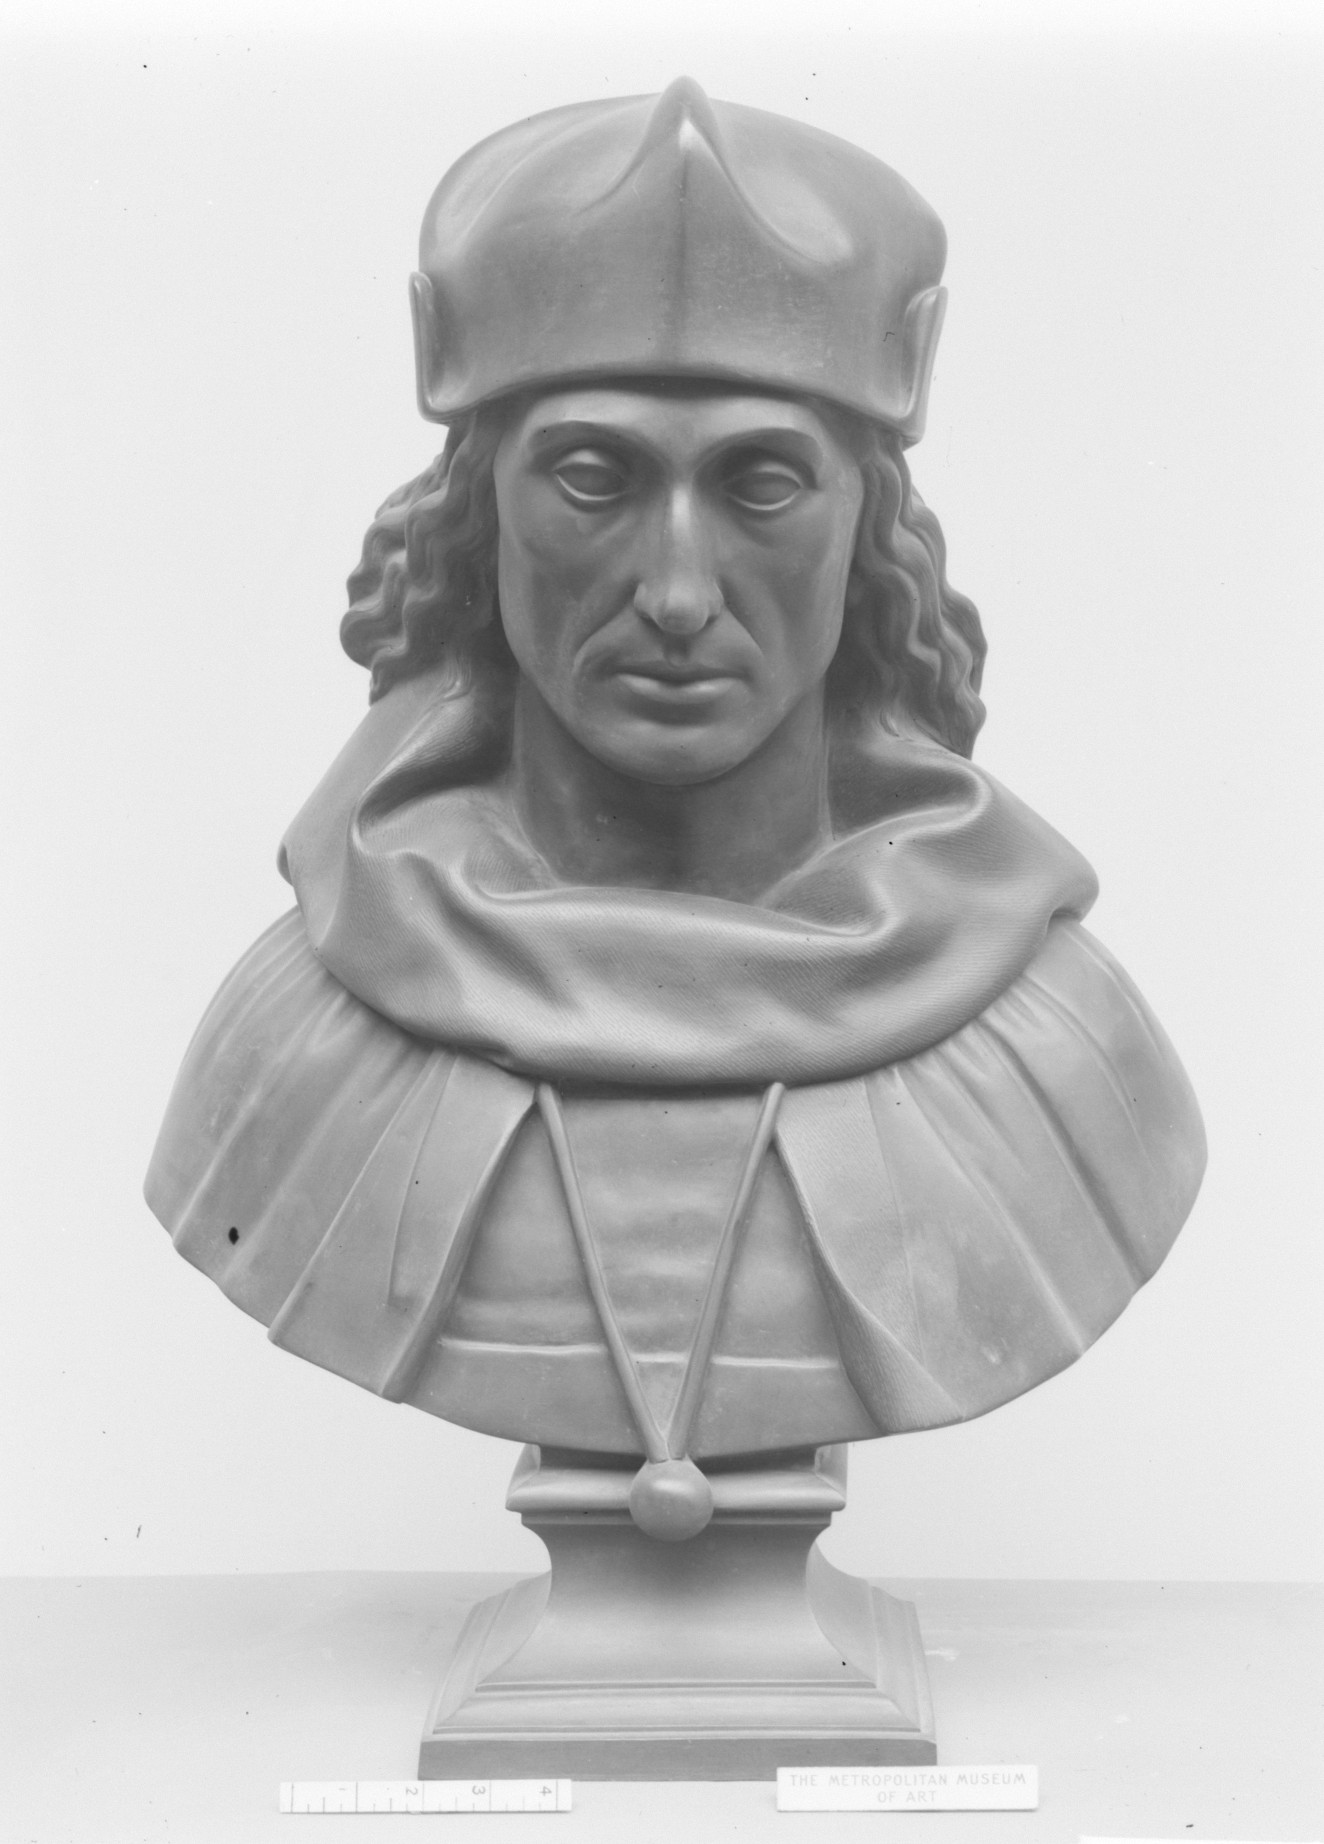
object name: bust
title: Henry VII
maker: pietro torrigiano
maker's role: artist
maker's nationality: italian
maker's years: 1472-1528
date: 1867-1900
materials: bronze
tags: men,portraits